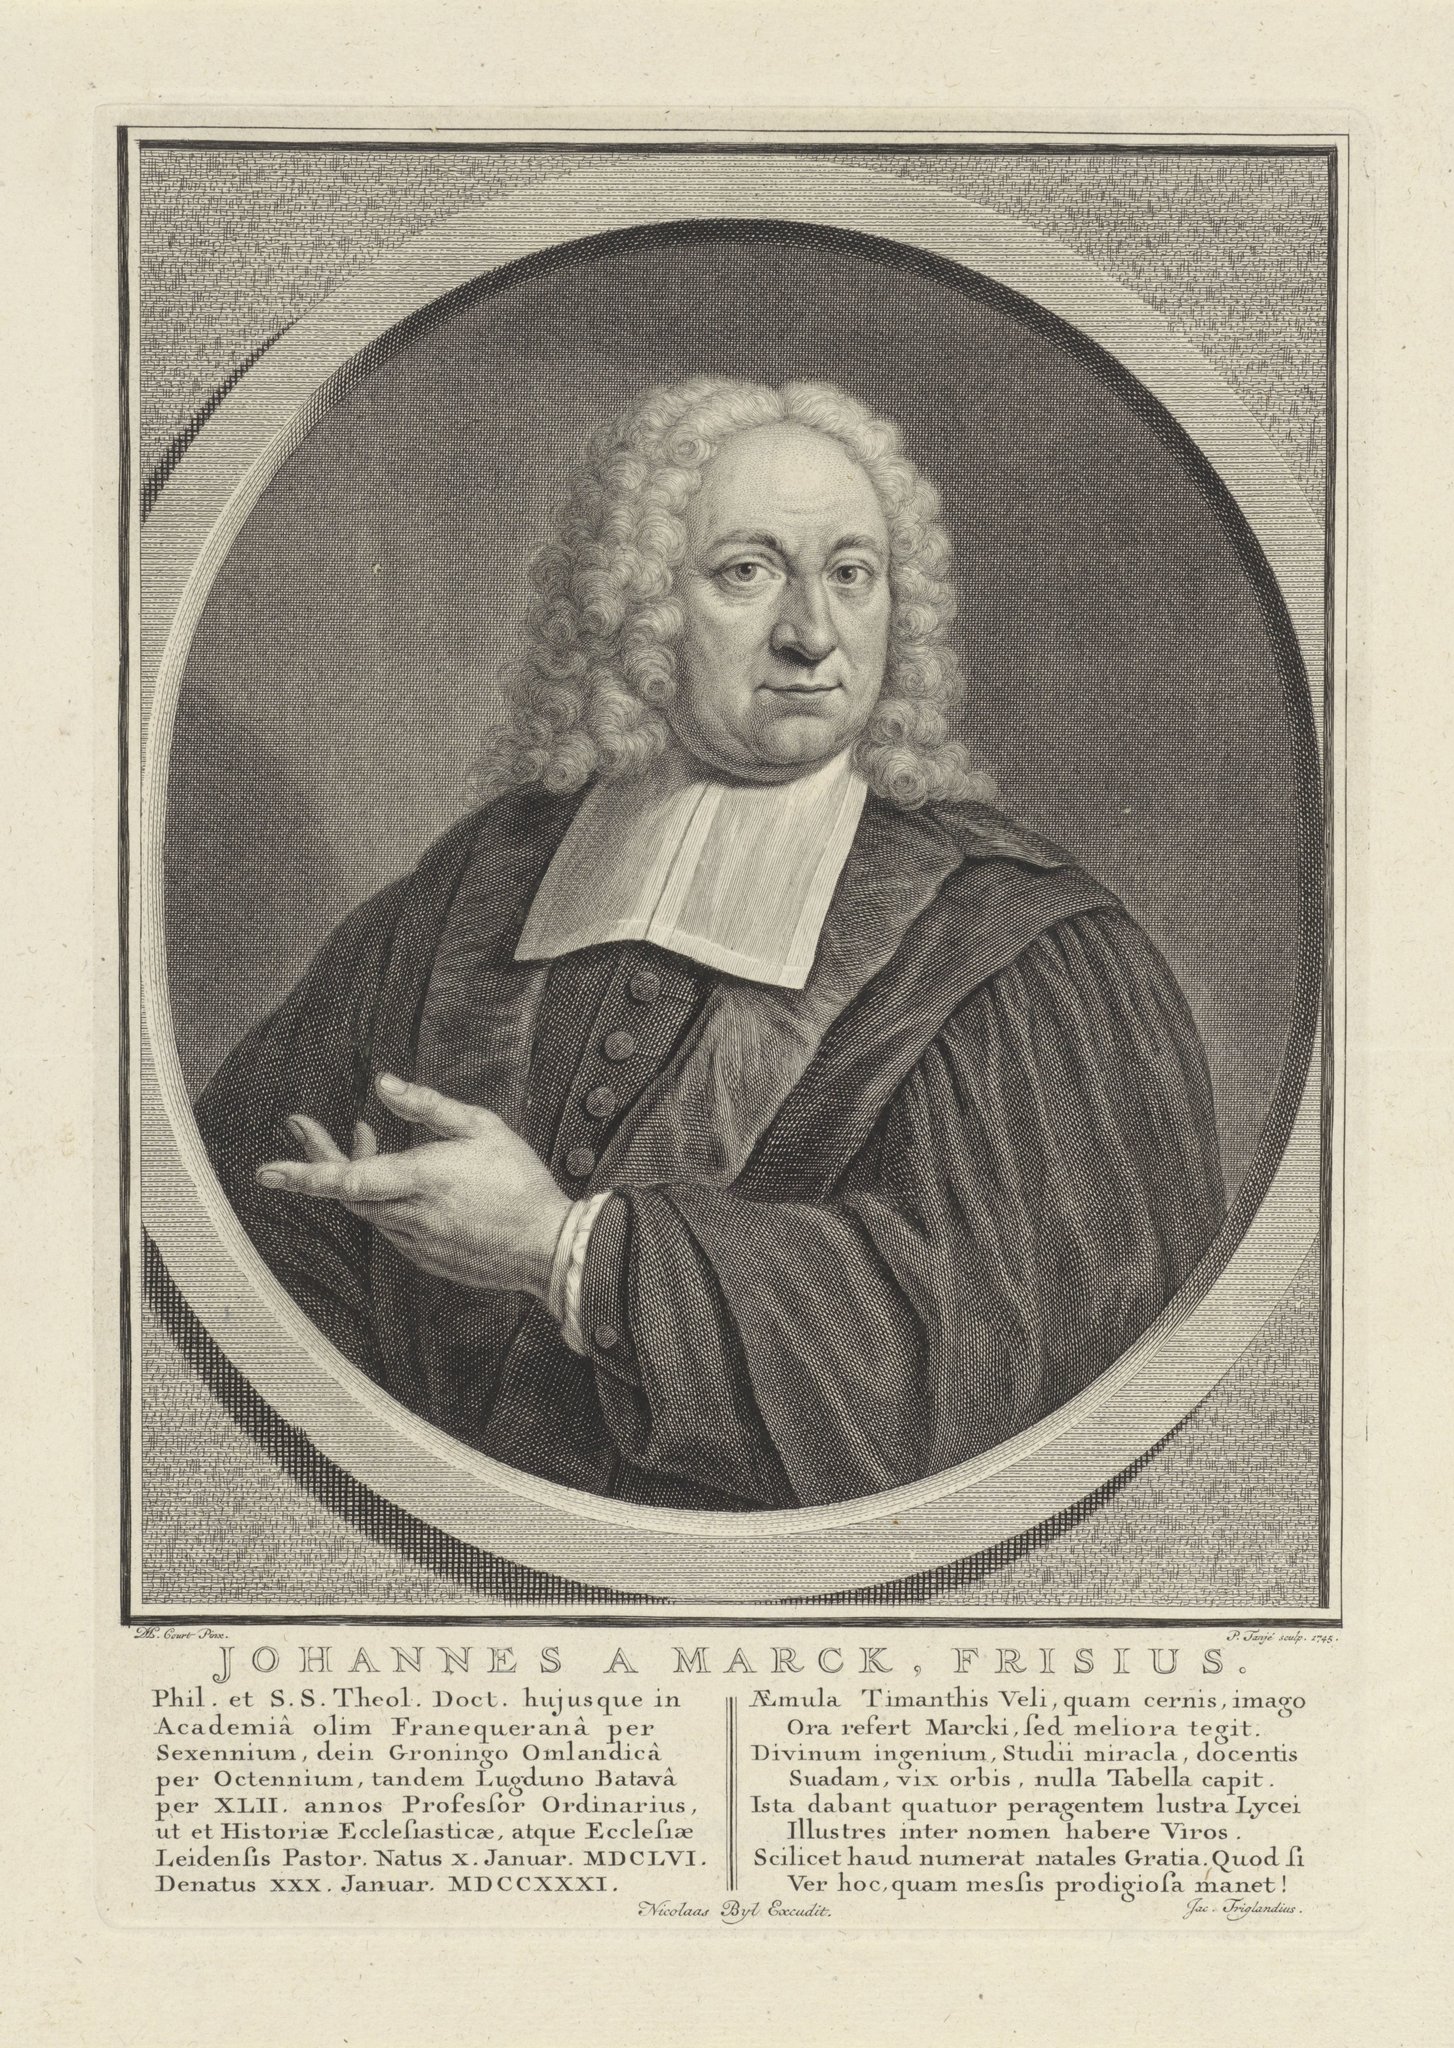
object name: print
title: Portret van Johannes à Marck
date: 1745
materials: paper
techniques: engraving, etching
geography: amsterdam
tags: leiden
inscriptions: collector's mark: Lugt 2228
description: Predikant en hoogleraar in de theologie Johannes à Marck gekleed in toga met witte bef. Onderaan in de marge een tekst in het Latijn.